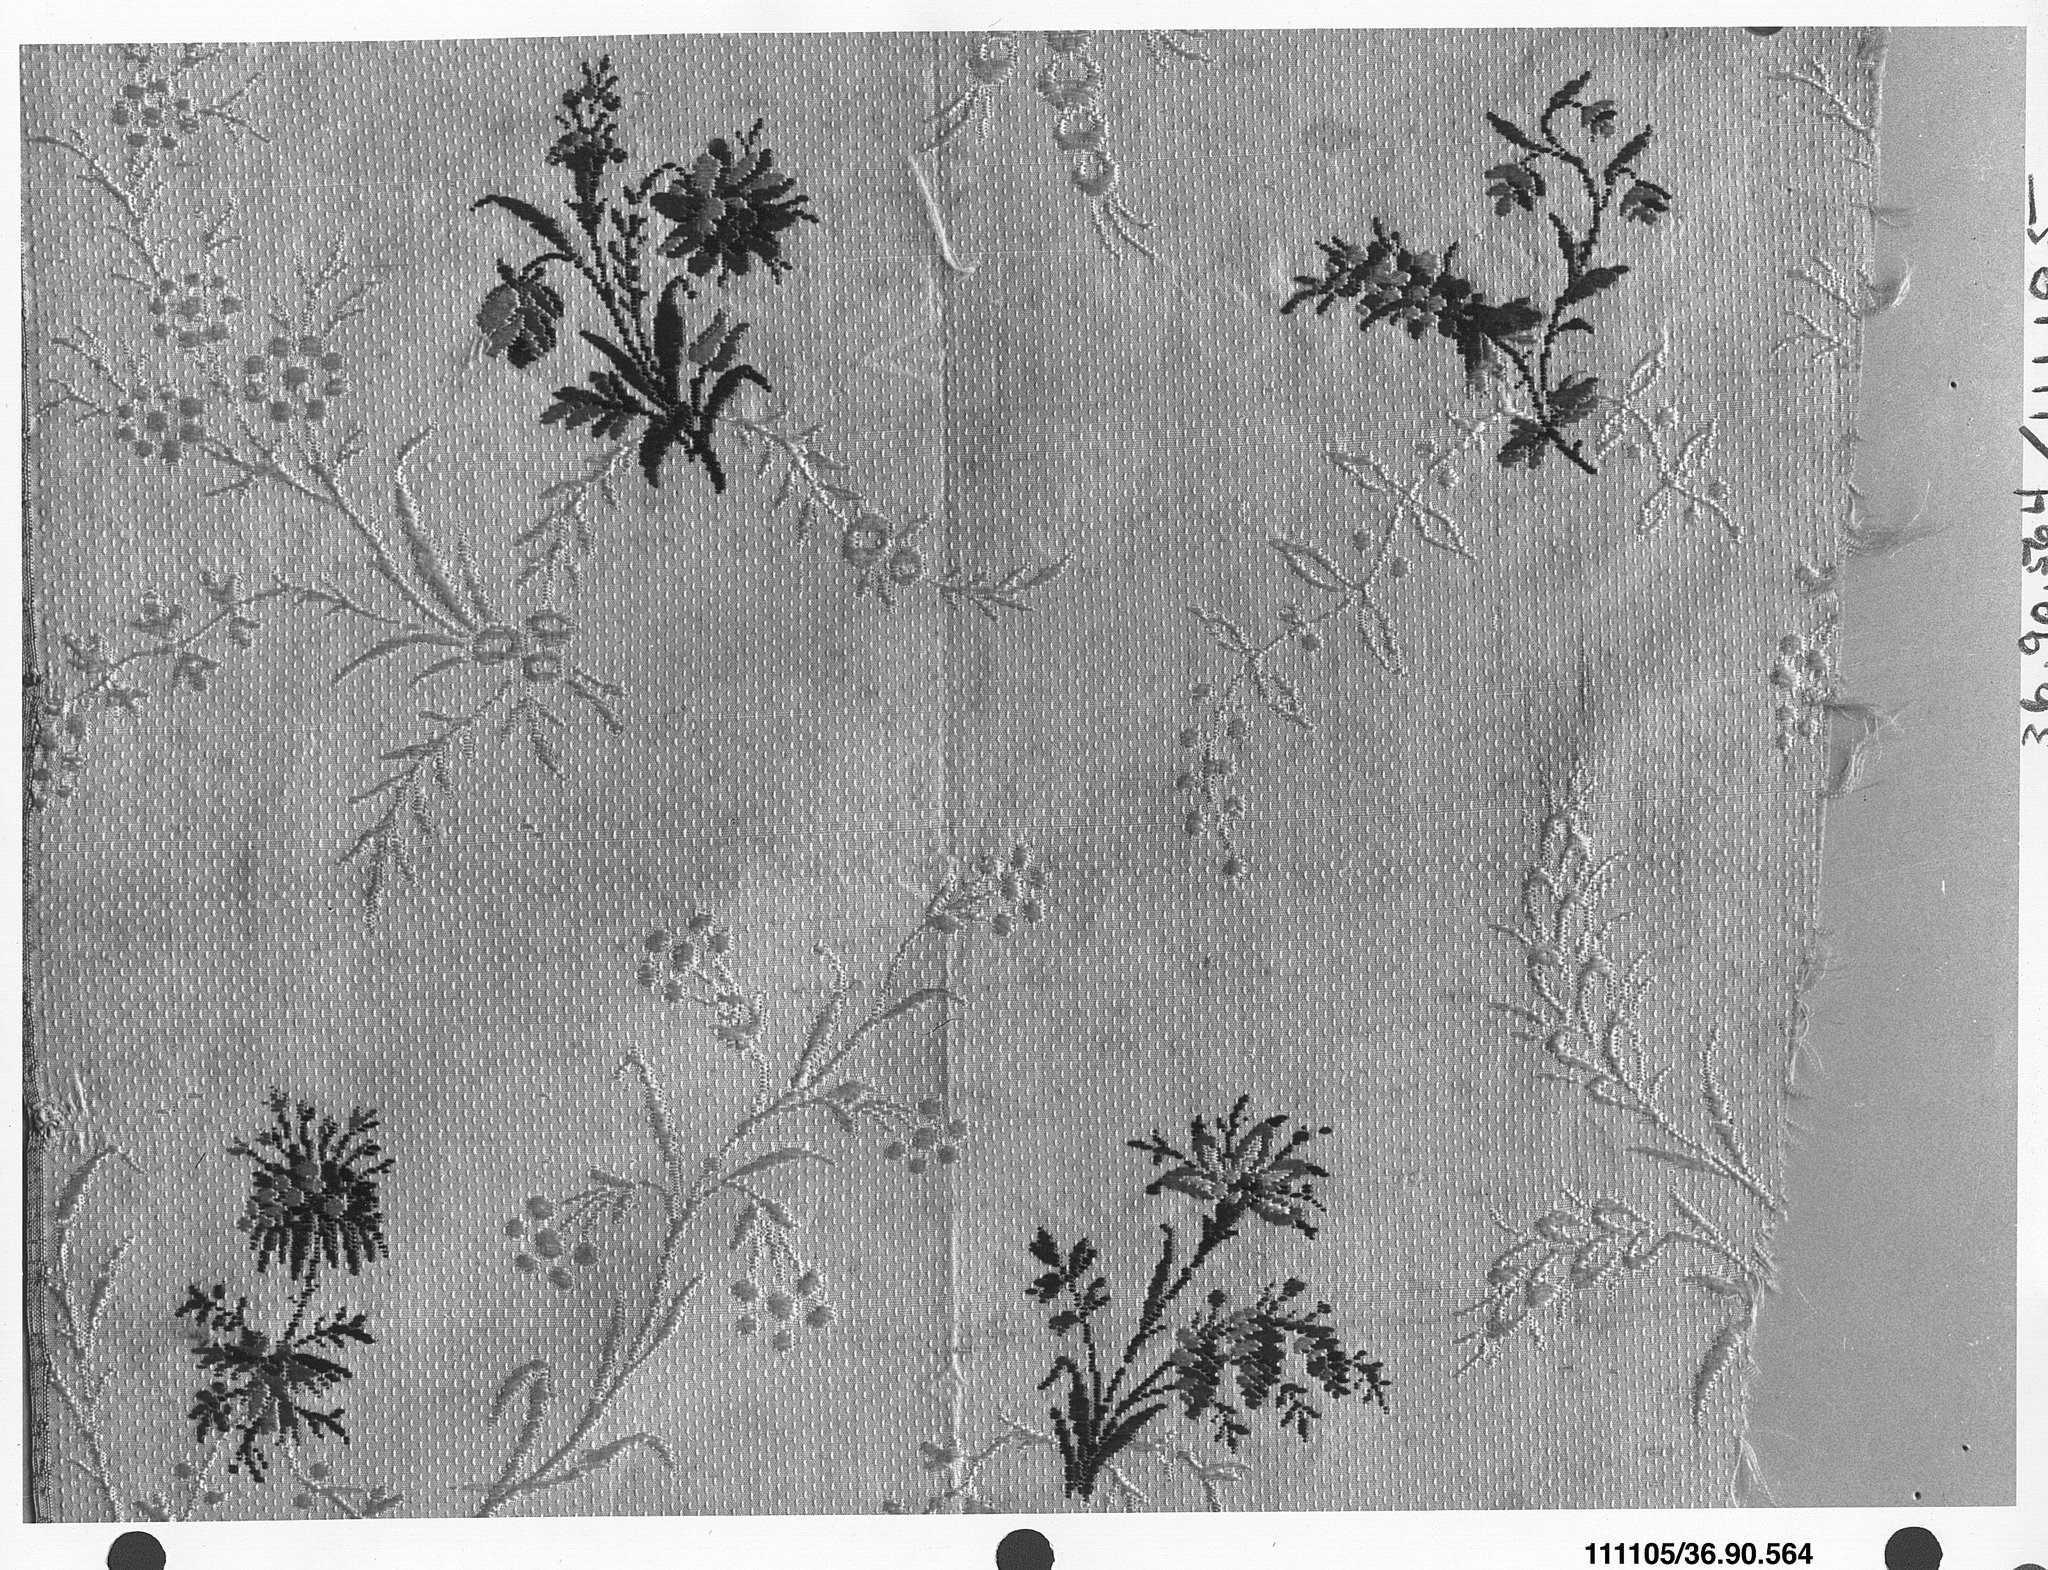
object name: piece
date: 1760-1770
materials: silk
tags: flowers,leaves